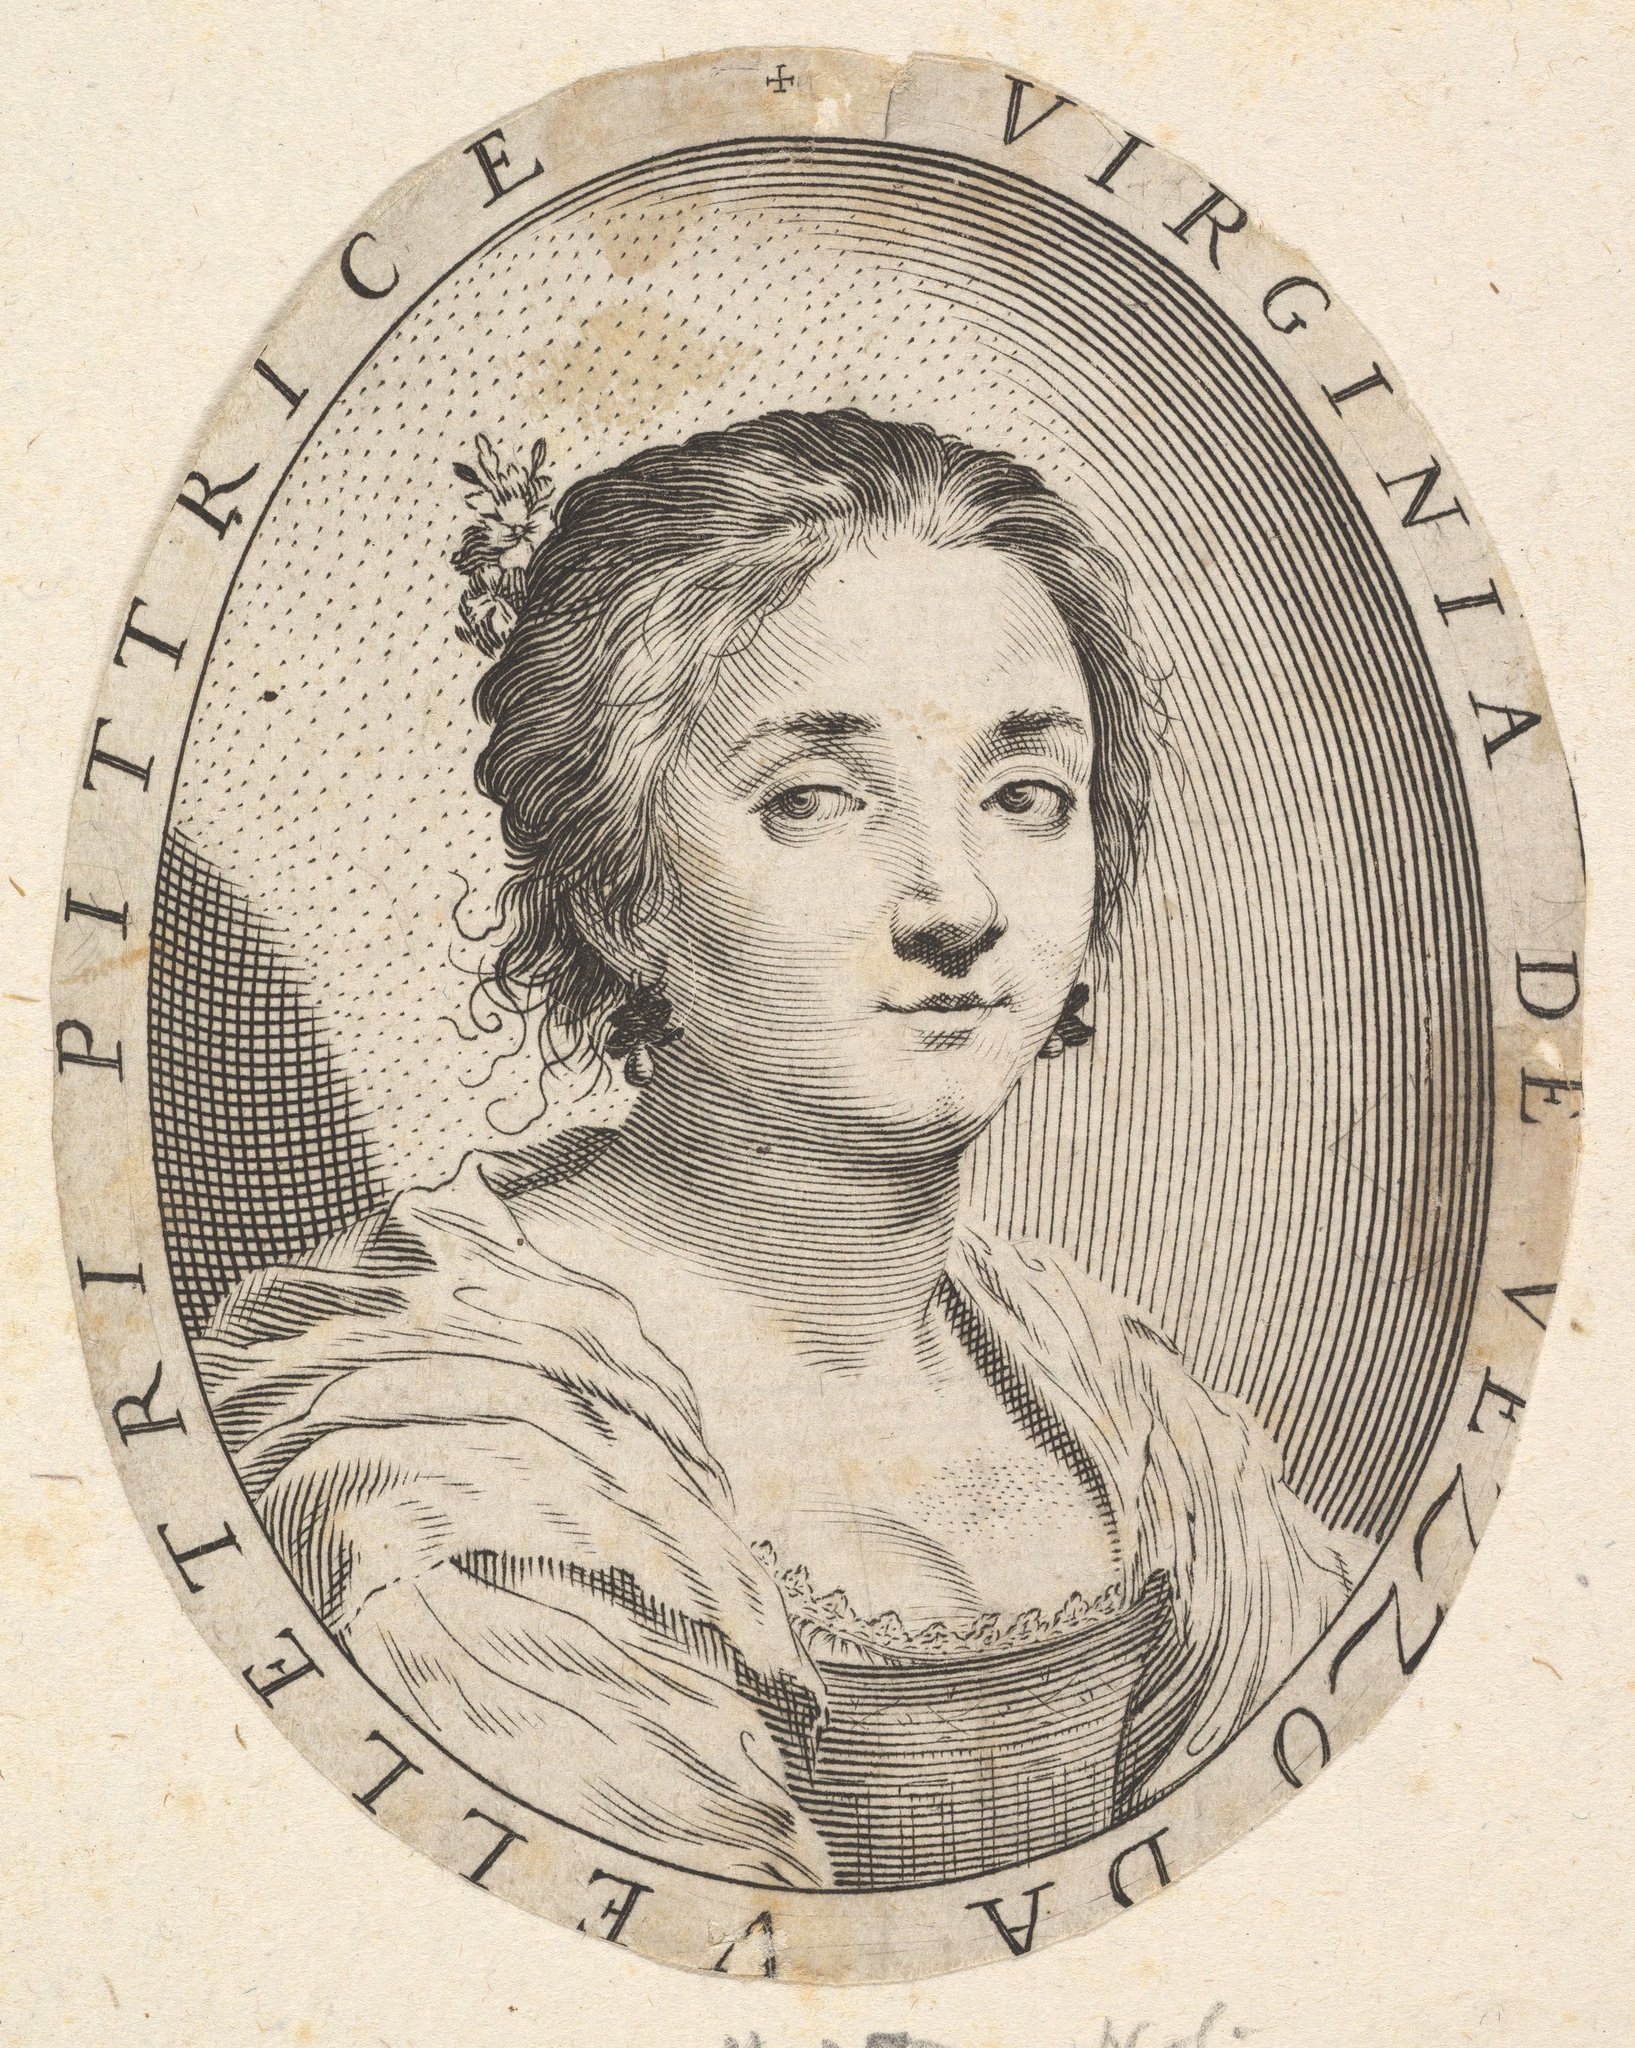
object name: print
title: Virginia da Vezzo, Wife of Simon Vouet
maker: claude mellan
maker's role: artist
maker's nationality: french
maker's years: 1598-1688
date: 1626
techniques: engraving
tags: portraits,women